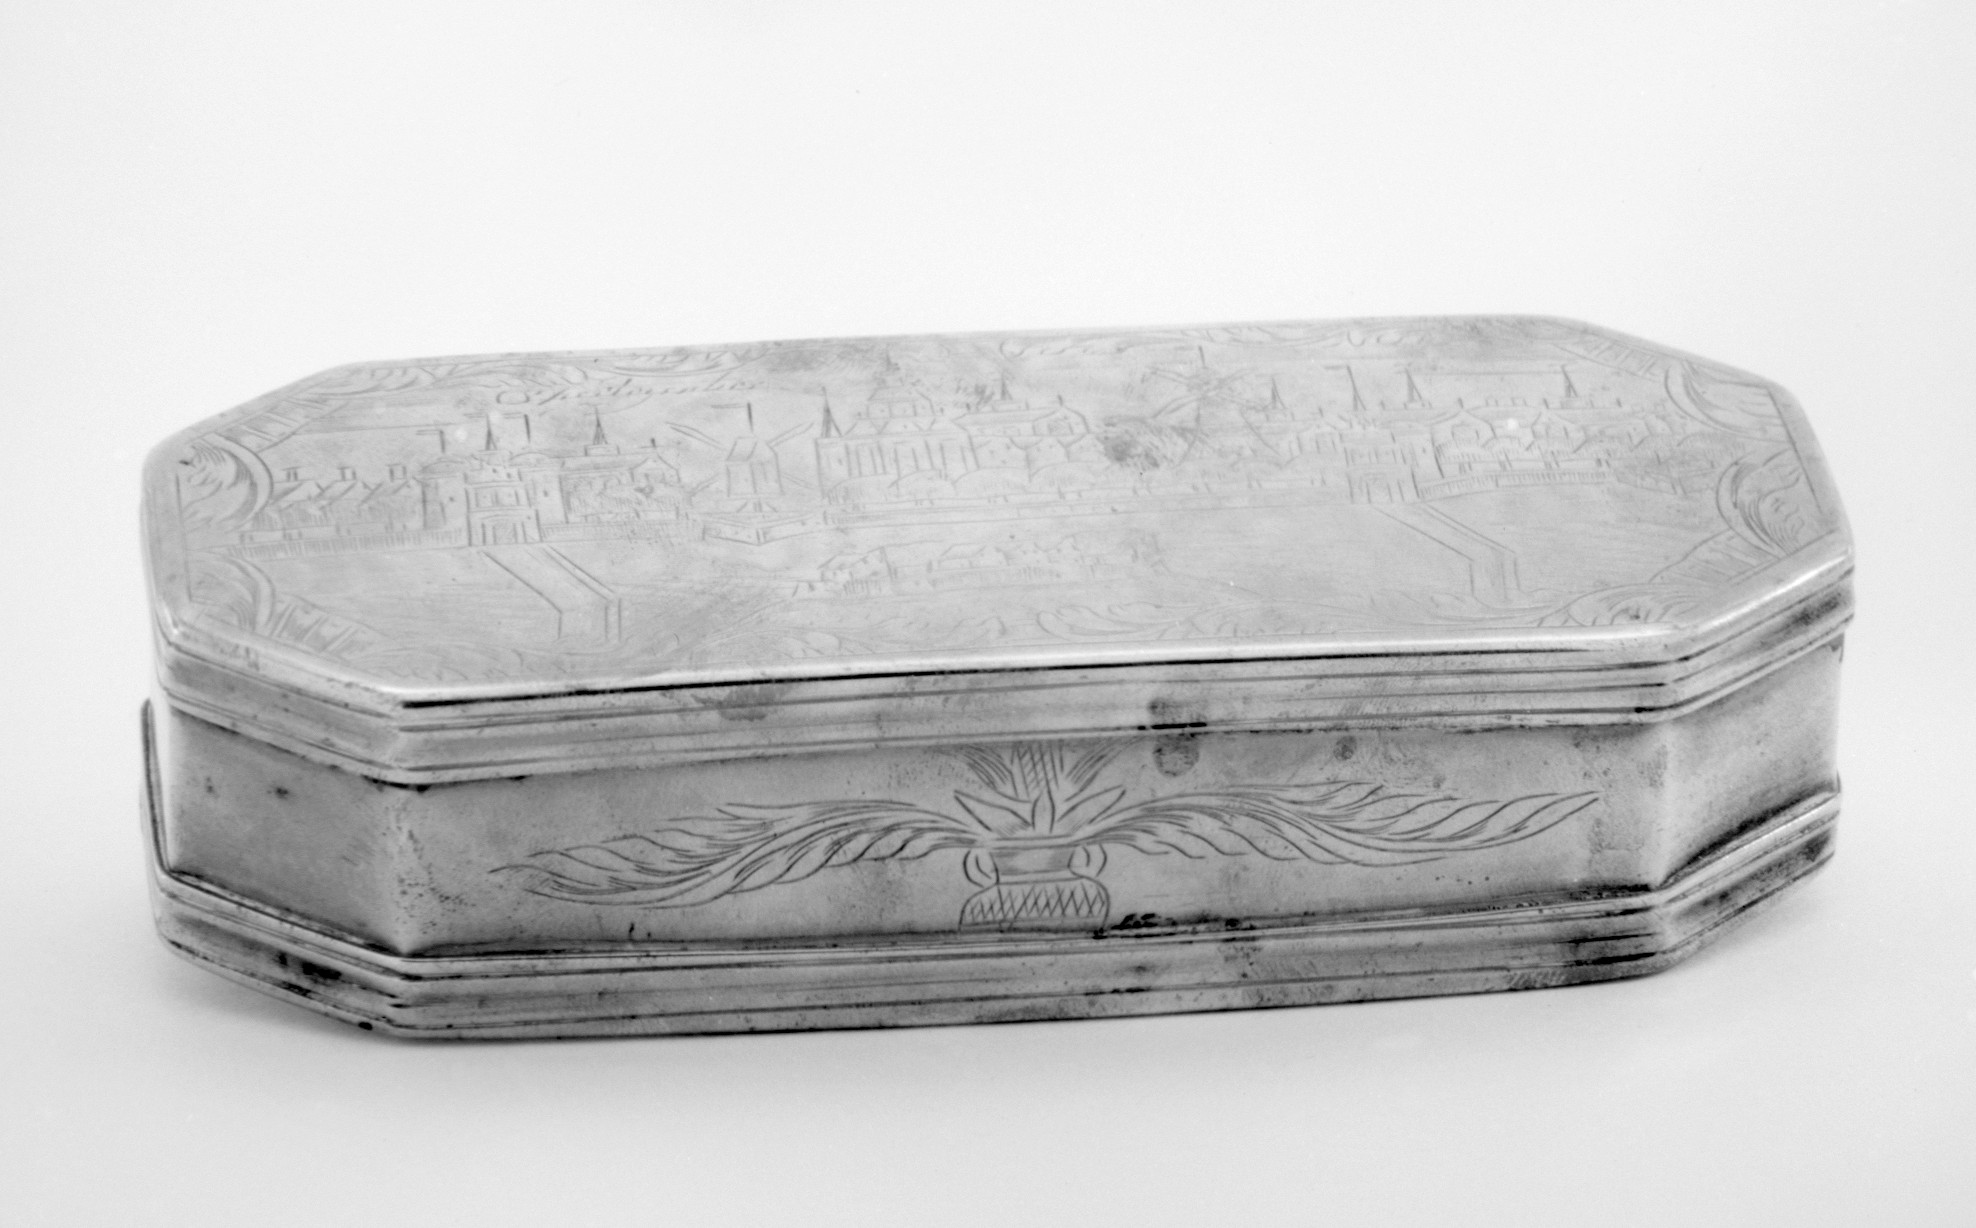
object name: tobacco box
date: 1701-1800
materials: brass, copper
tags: buildings